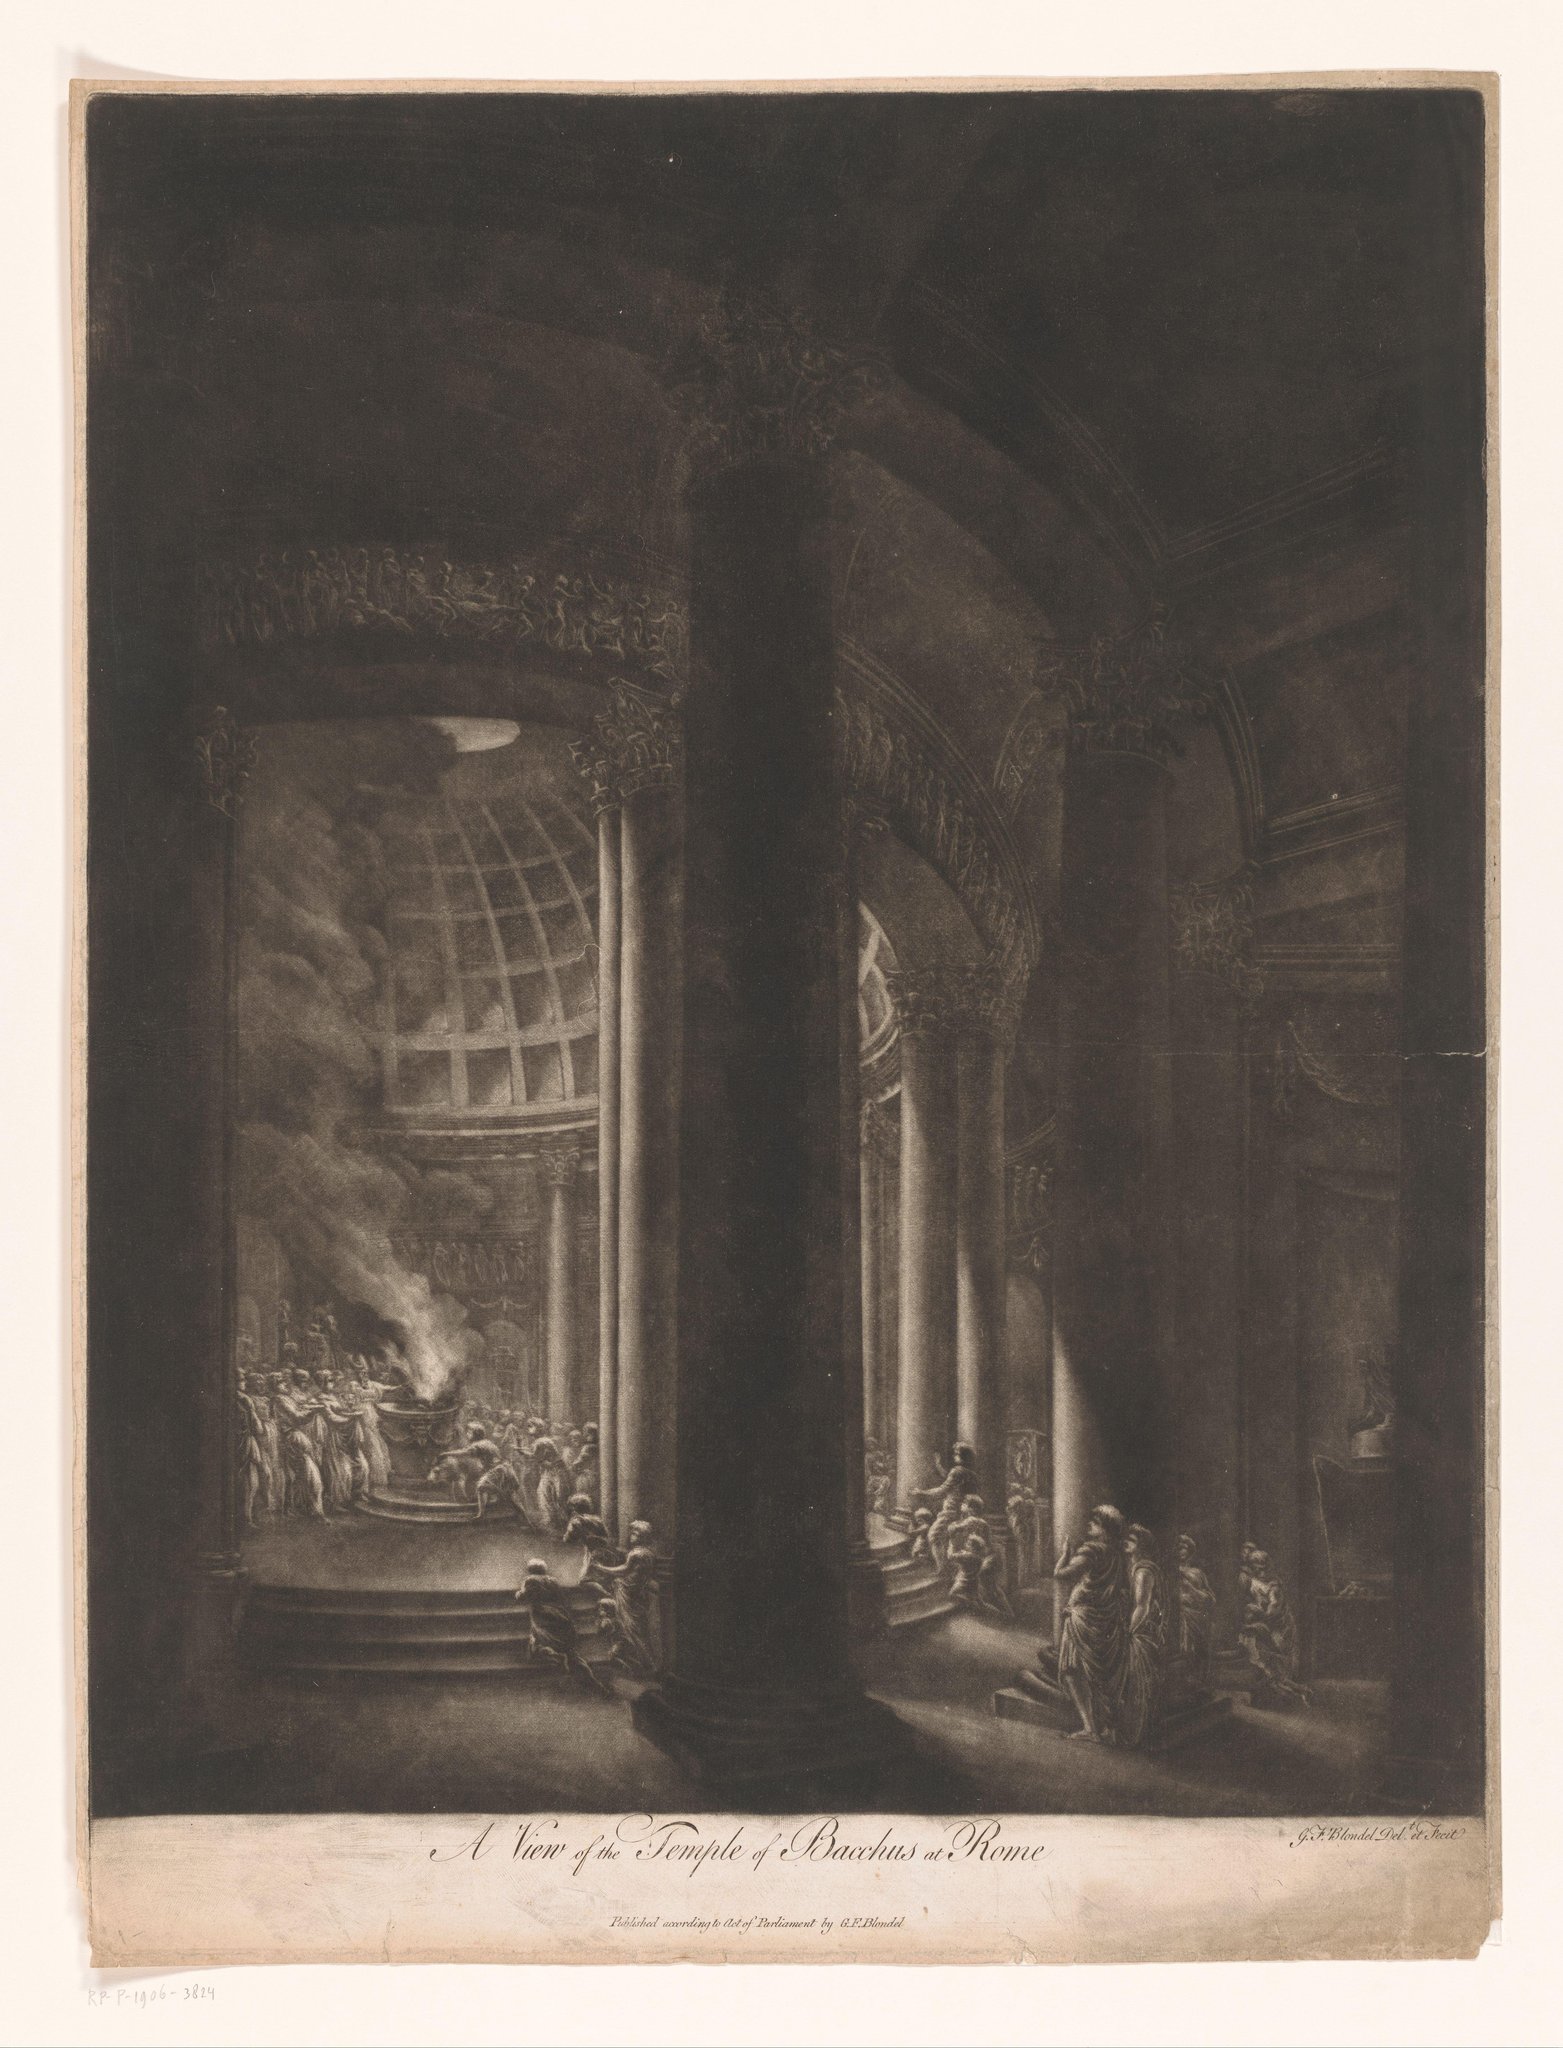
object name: print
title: Interieur van de tempel van Bacchus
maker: jacques françois blondel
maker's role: draughtsman, print maker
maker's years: 1705-1774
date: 1765-1767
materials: paper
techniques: mezzotint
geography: london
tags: temple, shrine ~ roman religion, rome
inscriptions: collector's mark: Lugt 2228a